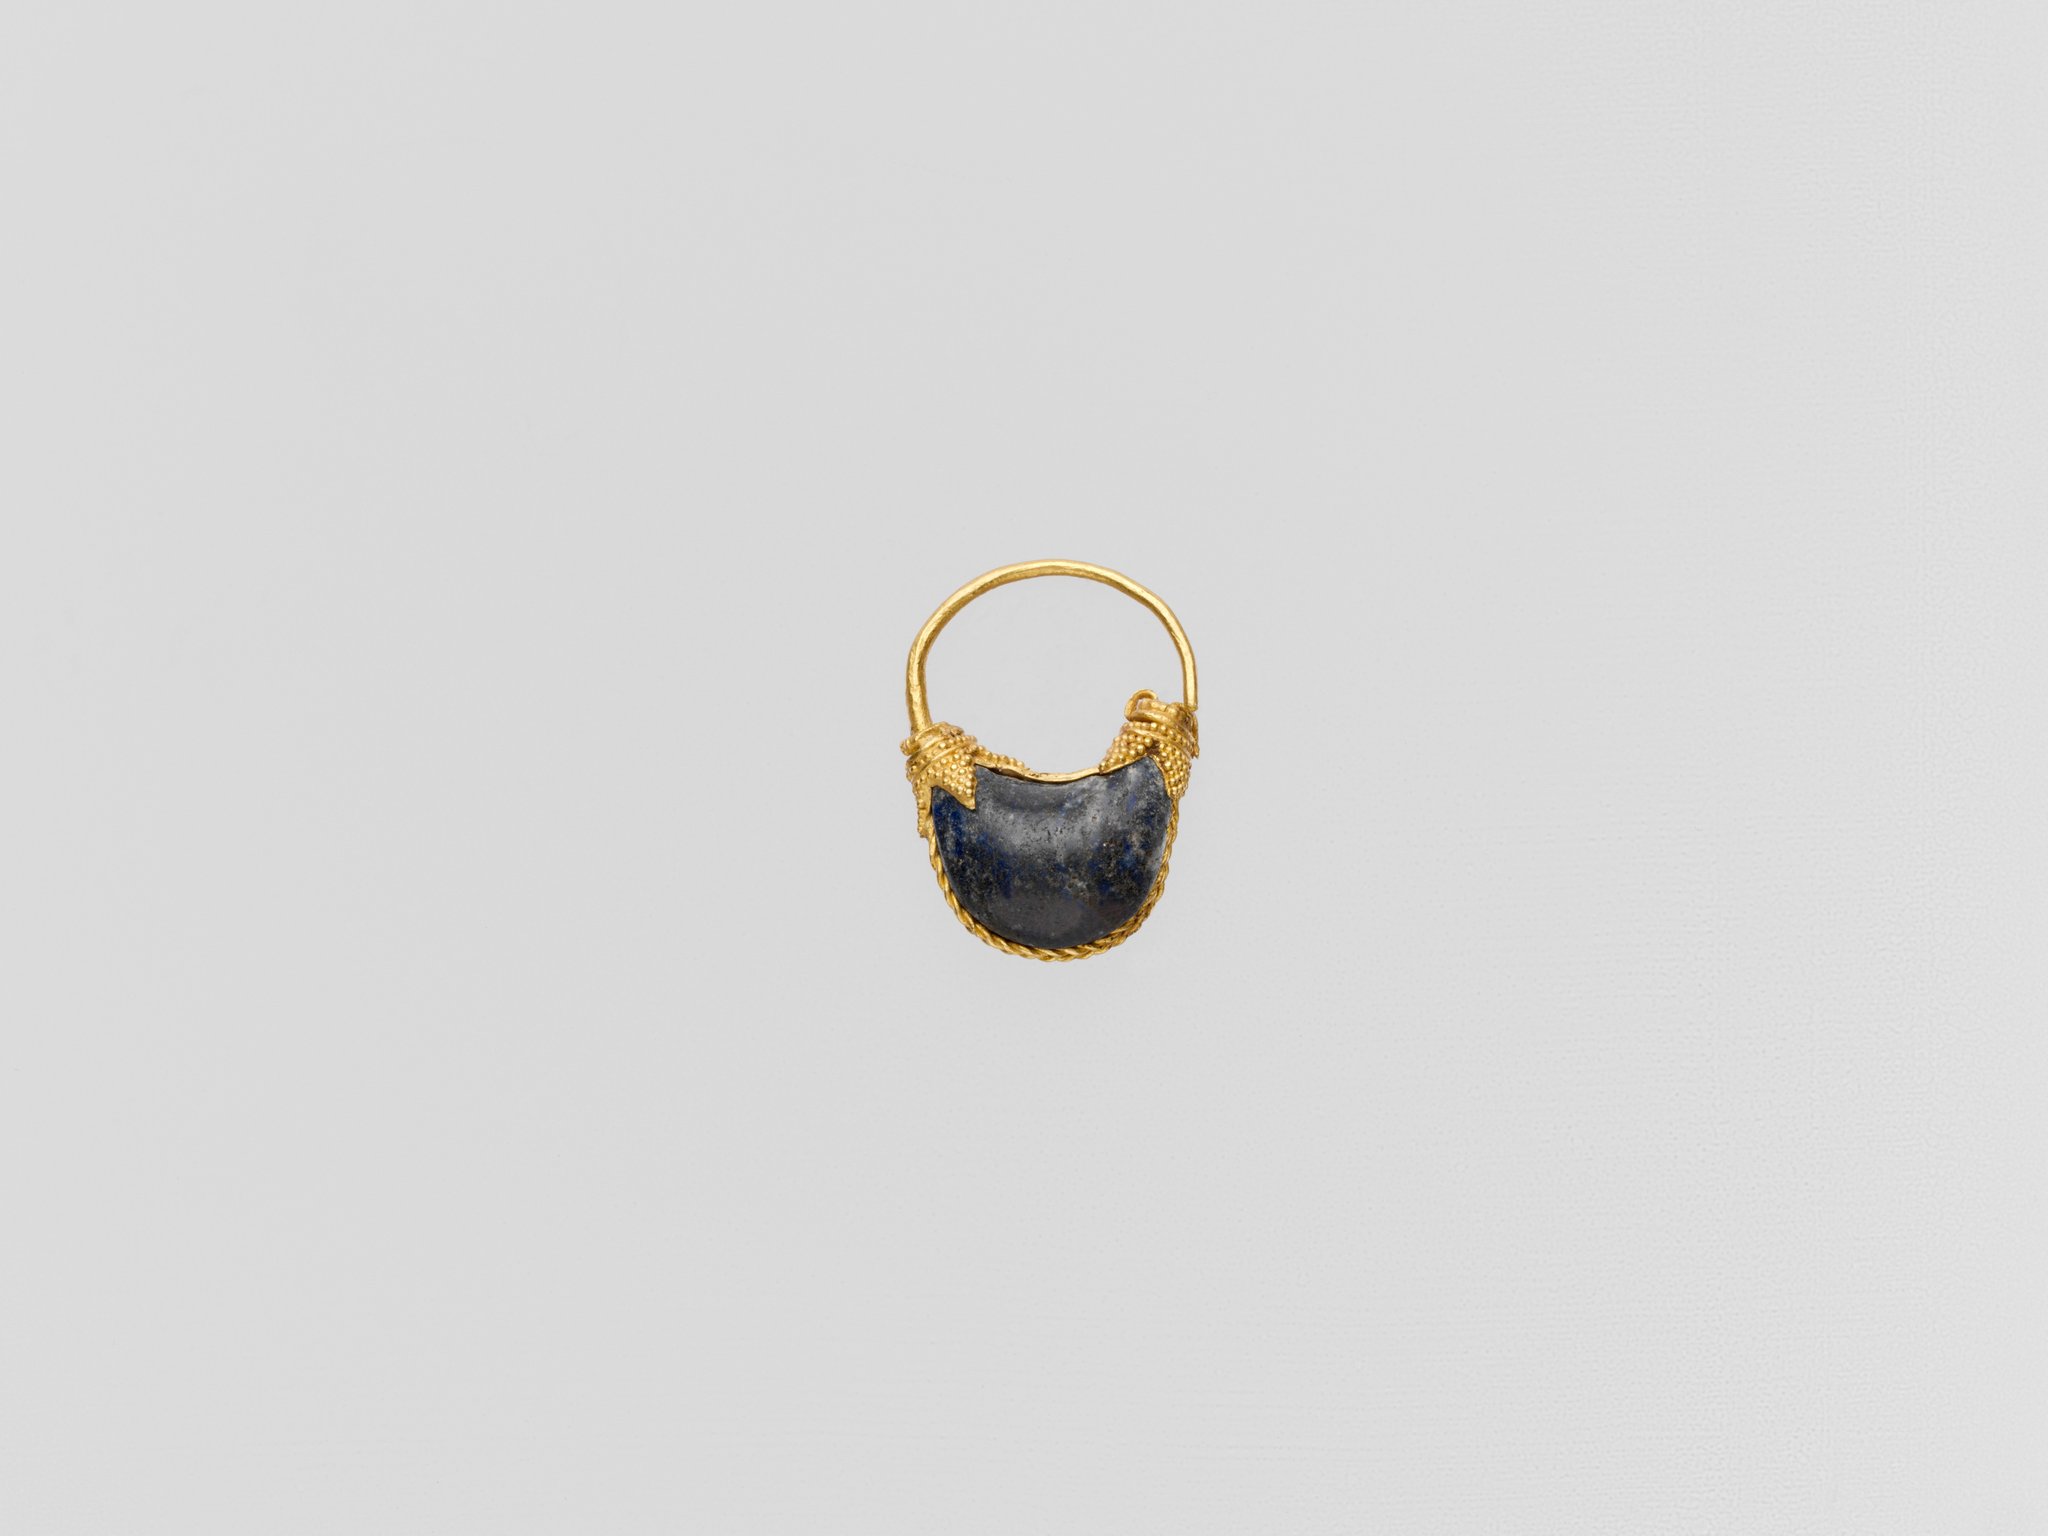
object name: earring, boat shaped with lapis lazuli setting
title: Gold and lapis-lazuli boat-shaped earring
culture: cypriot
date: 600-401 BCE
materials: gold, lapis lazuli